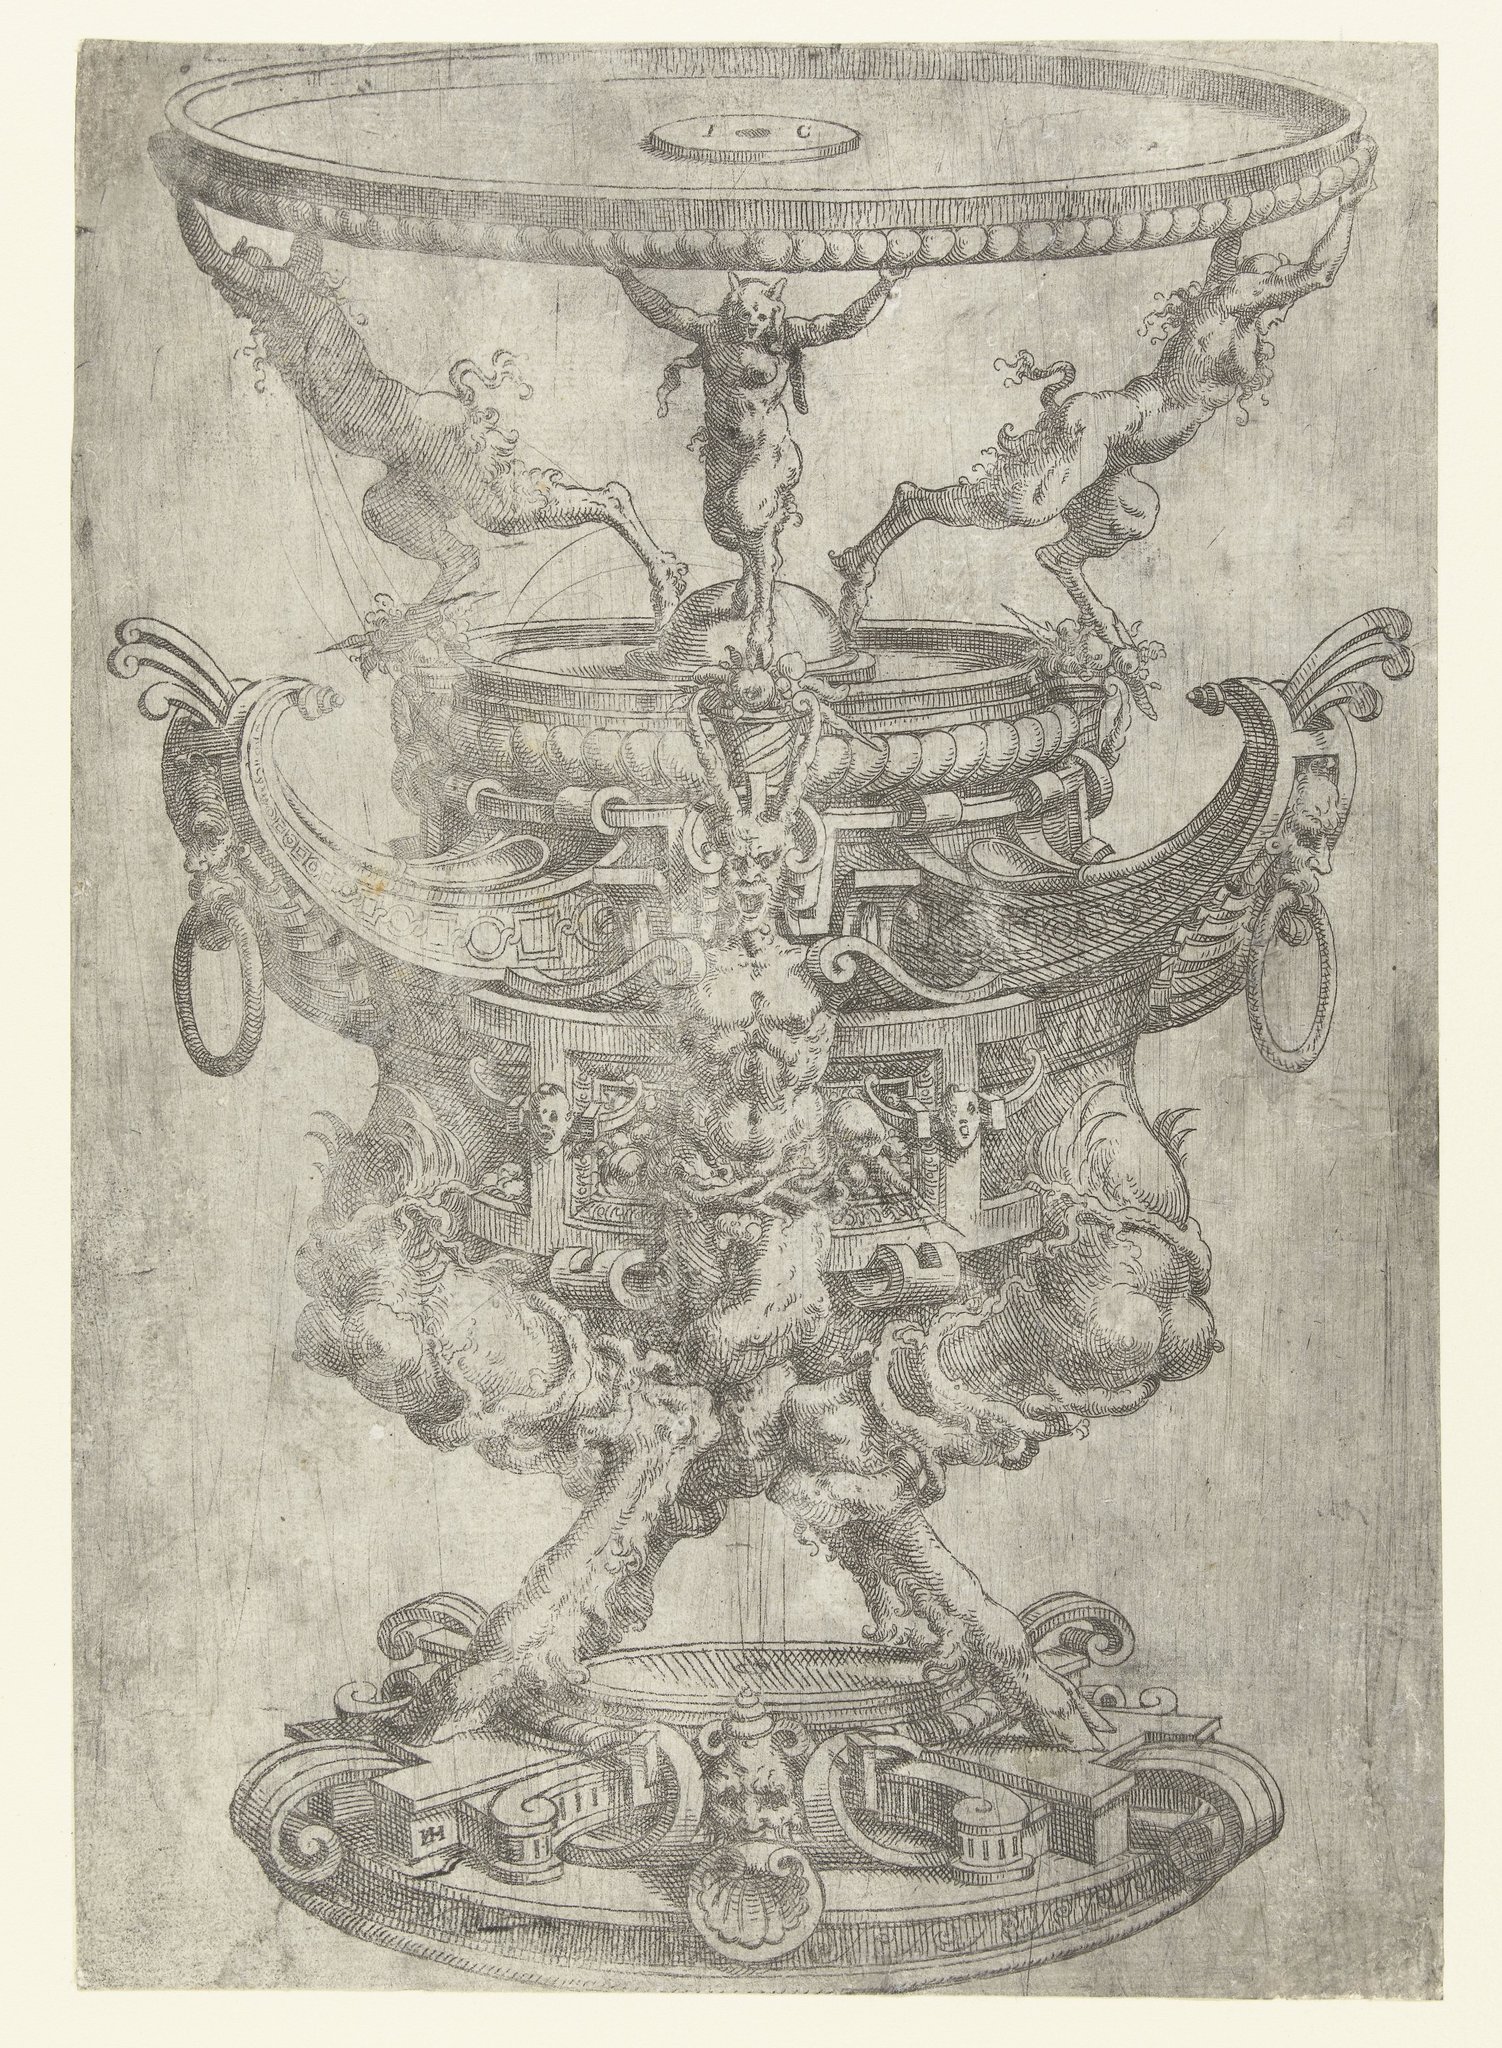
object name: print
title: Tafelfontein met rolwerk en grotesken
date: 1490-1540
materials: paper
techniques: etching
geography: france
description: De voet bestaat uit vier gehoefde poten. Daarboven hangt een sater tegen de buik van het waterbekken. Drie vrouwelijke saters dragen het plateau.